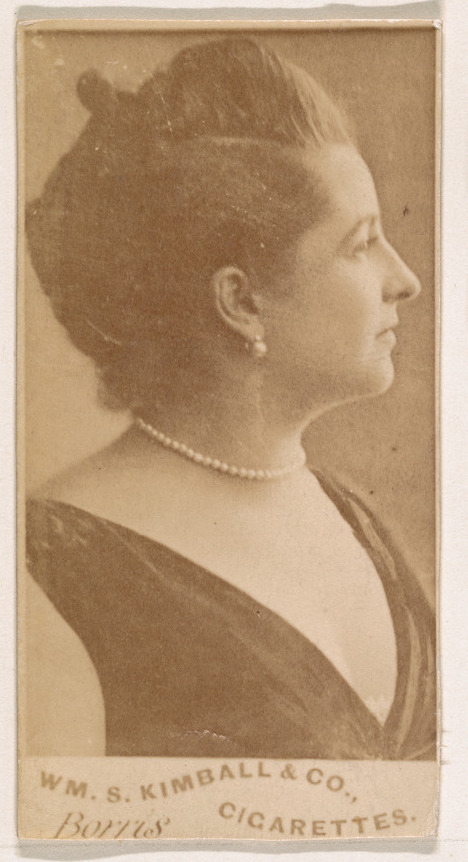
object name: photograph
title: Miss Borris, from the Actresses series (N203) issued by Wm. S. Kimball & Co.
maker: william s. kimball & company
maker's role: publisher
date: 1889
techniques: color lithograph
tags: portraits,women,actresses